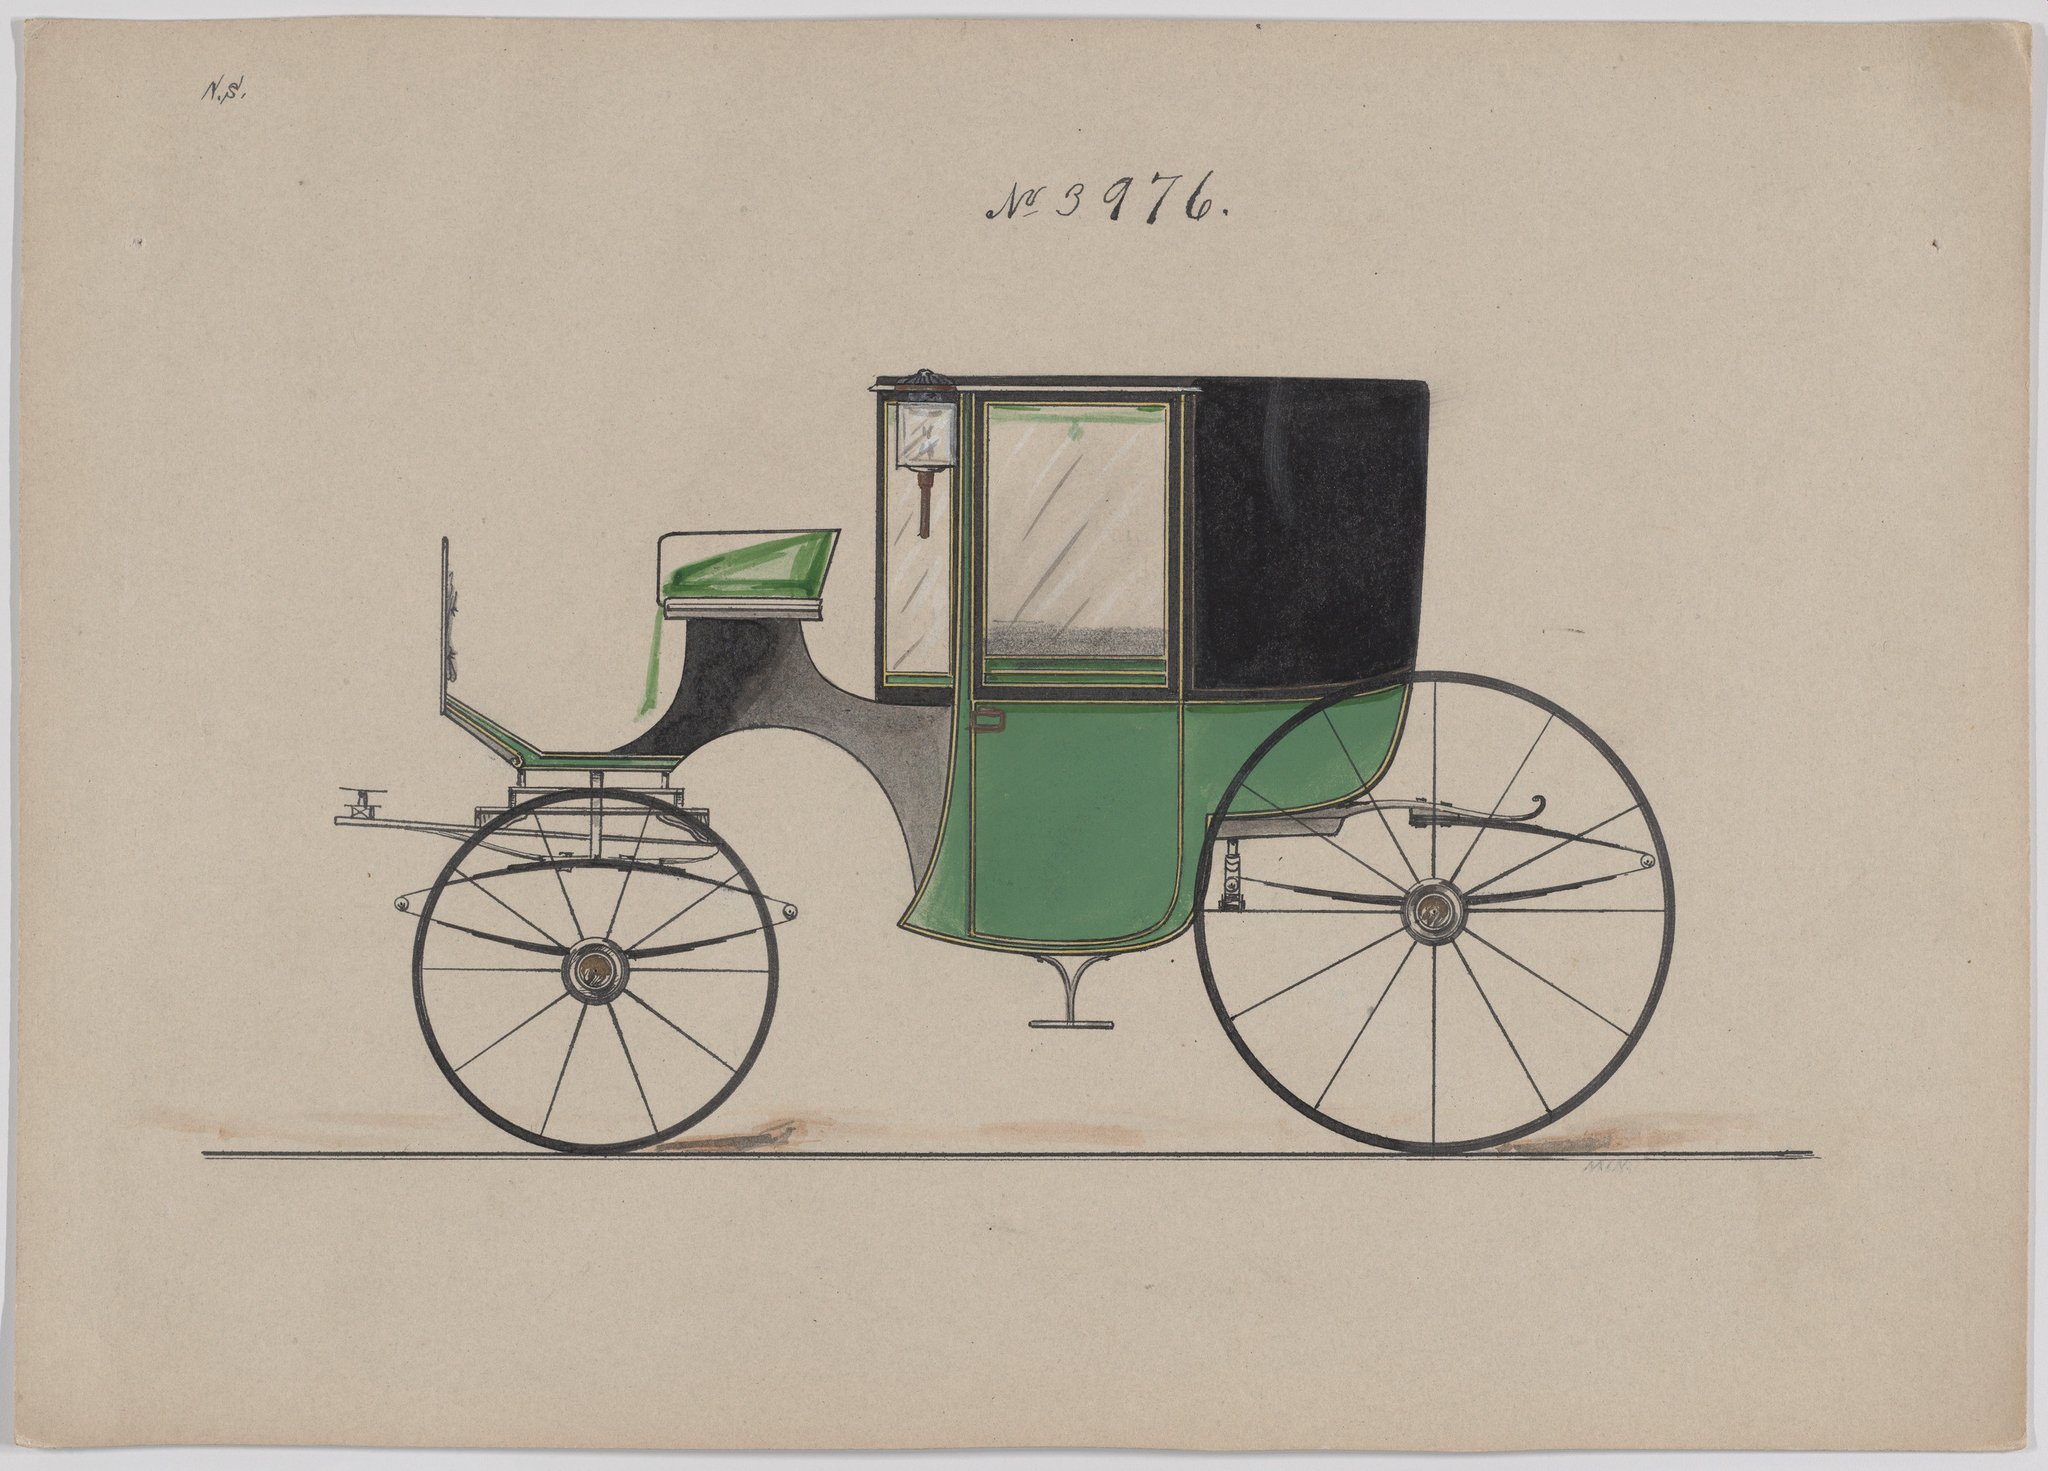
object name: drawing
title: Design for Coupé, no. 3976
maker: brewster & co.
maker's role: manufacturer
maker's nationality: american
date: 1886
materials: gouache, gum arabic, ink, watercolor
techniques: pen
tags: carriages